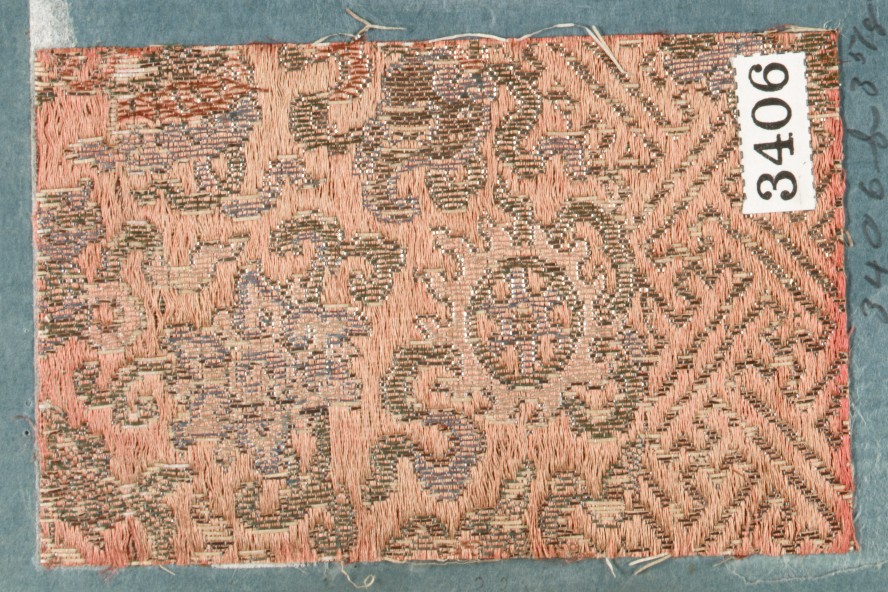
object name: textile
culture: japanese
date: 1801-1900